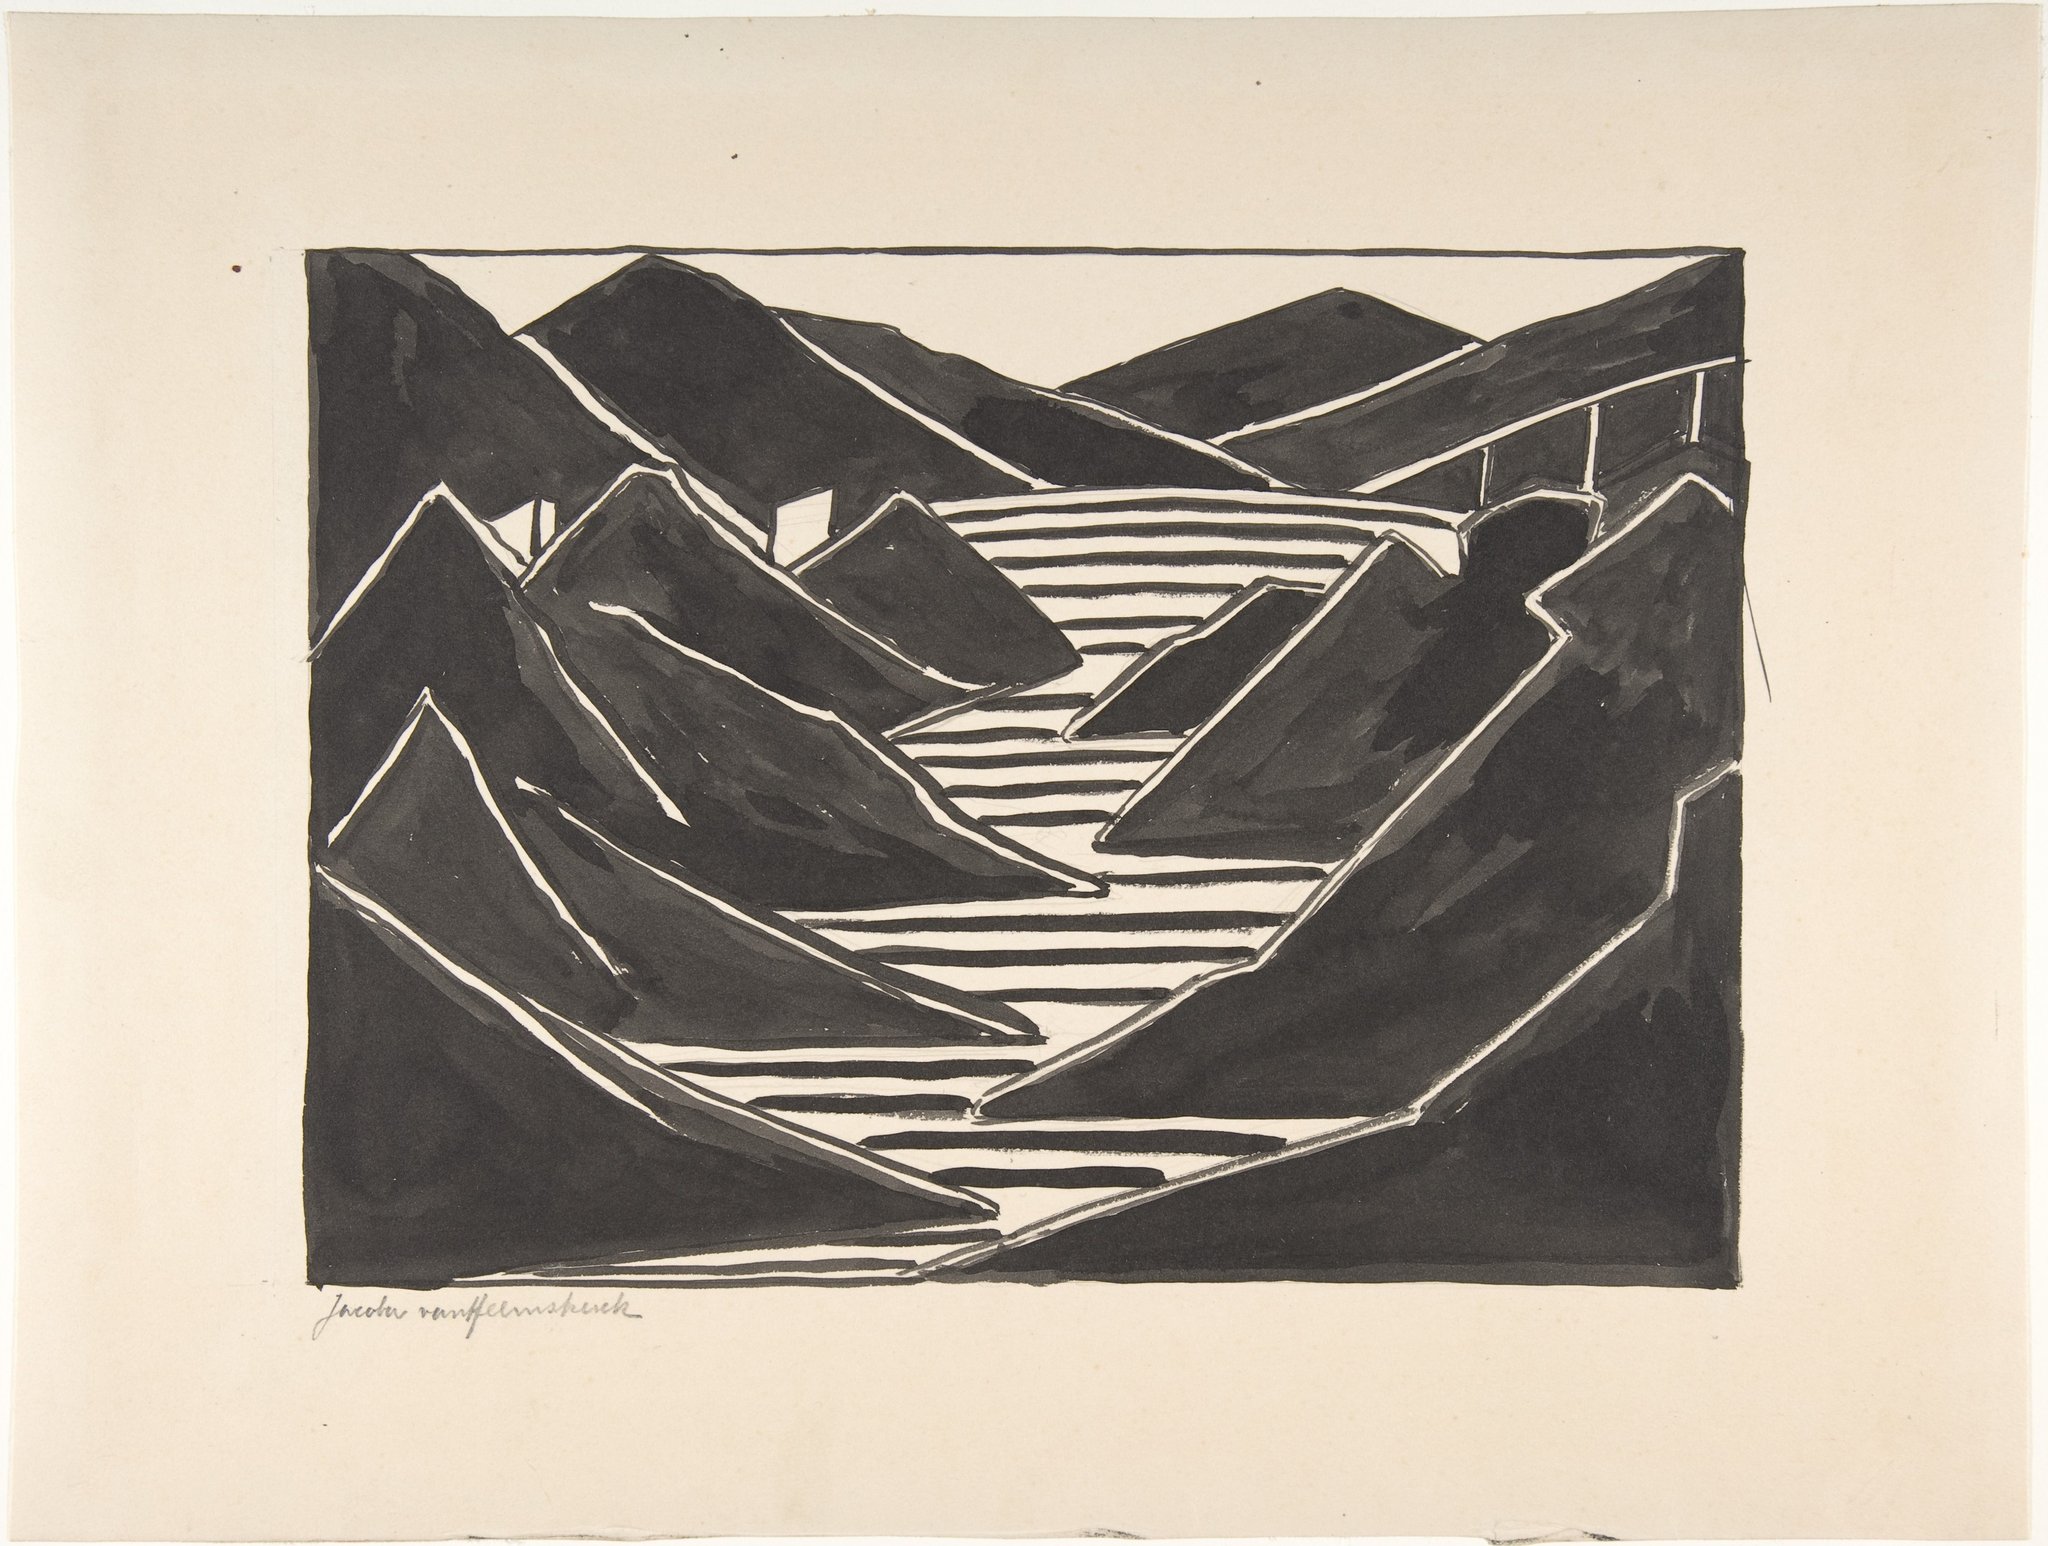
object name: drawing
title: Composition (Fjord)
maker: jacoba van heemskerck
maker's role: artist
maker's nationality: dutch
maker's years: 1876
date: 1915-1916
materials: ink, pencil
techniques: brush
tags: landscapes